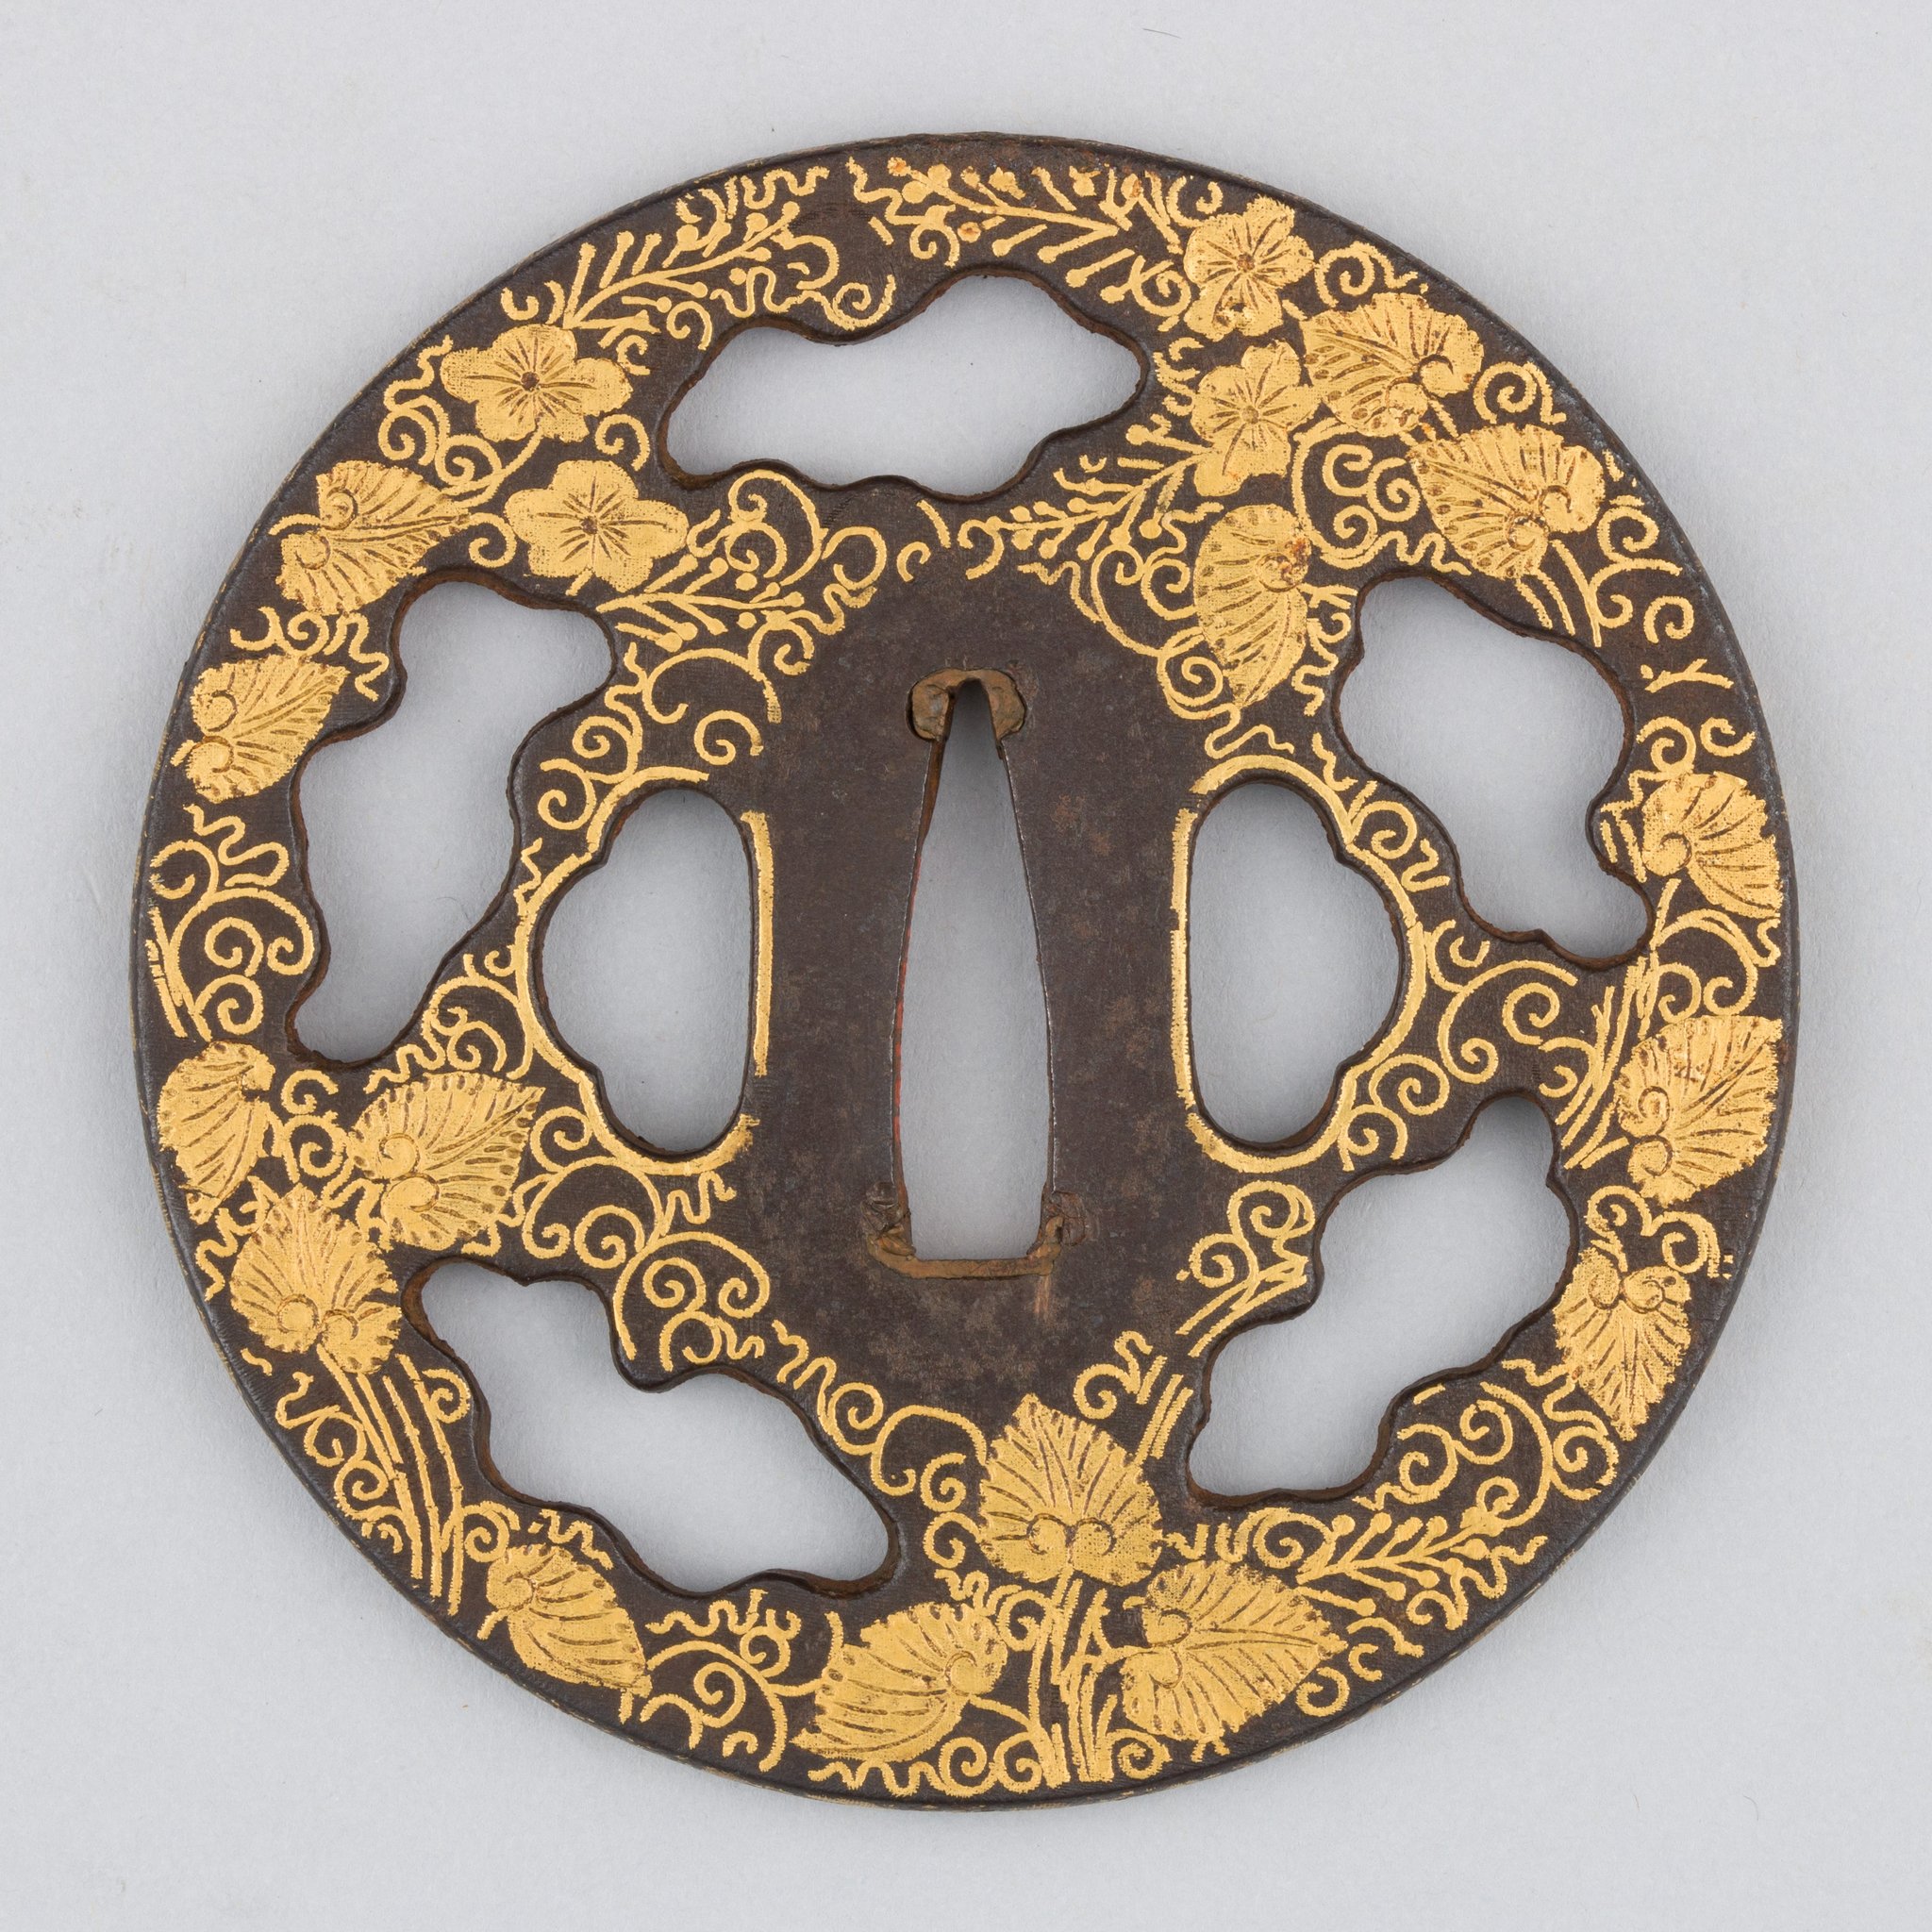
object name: sword guard tsuba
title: Sword Guard (Tsuba)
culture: japanese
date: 1601-1700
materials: copper, gold, iron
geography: japan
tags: leaves